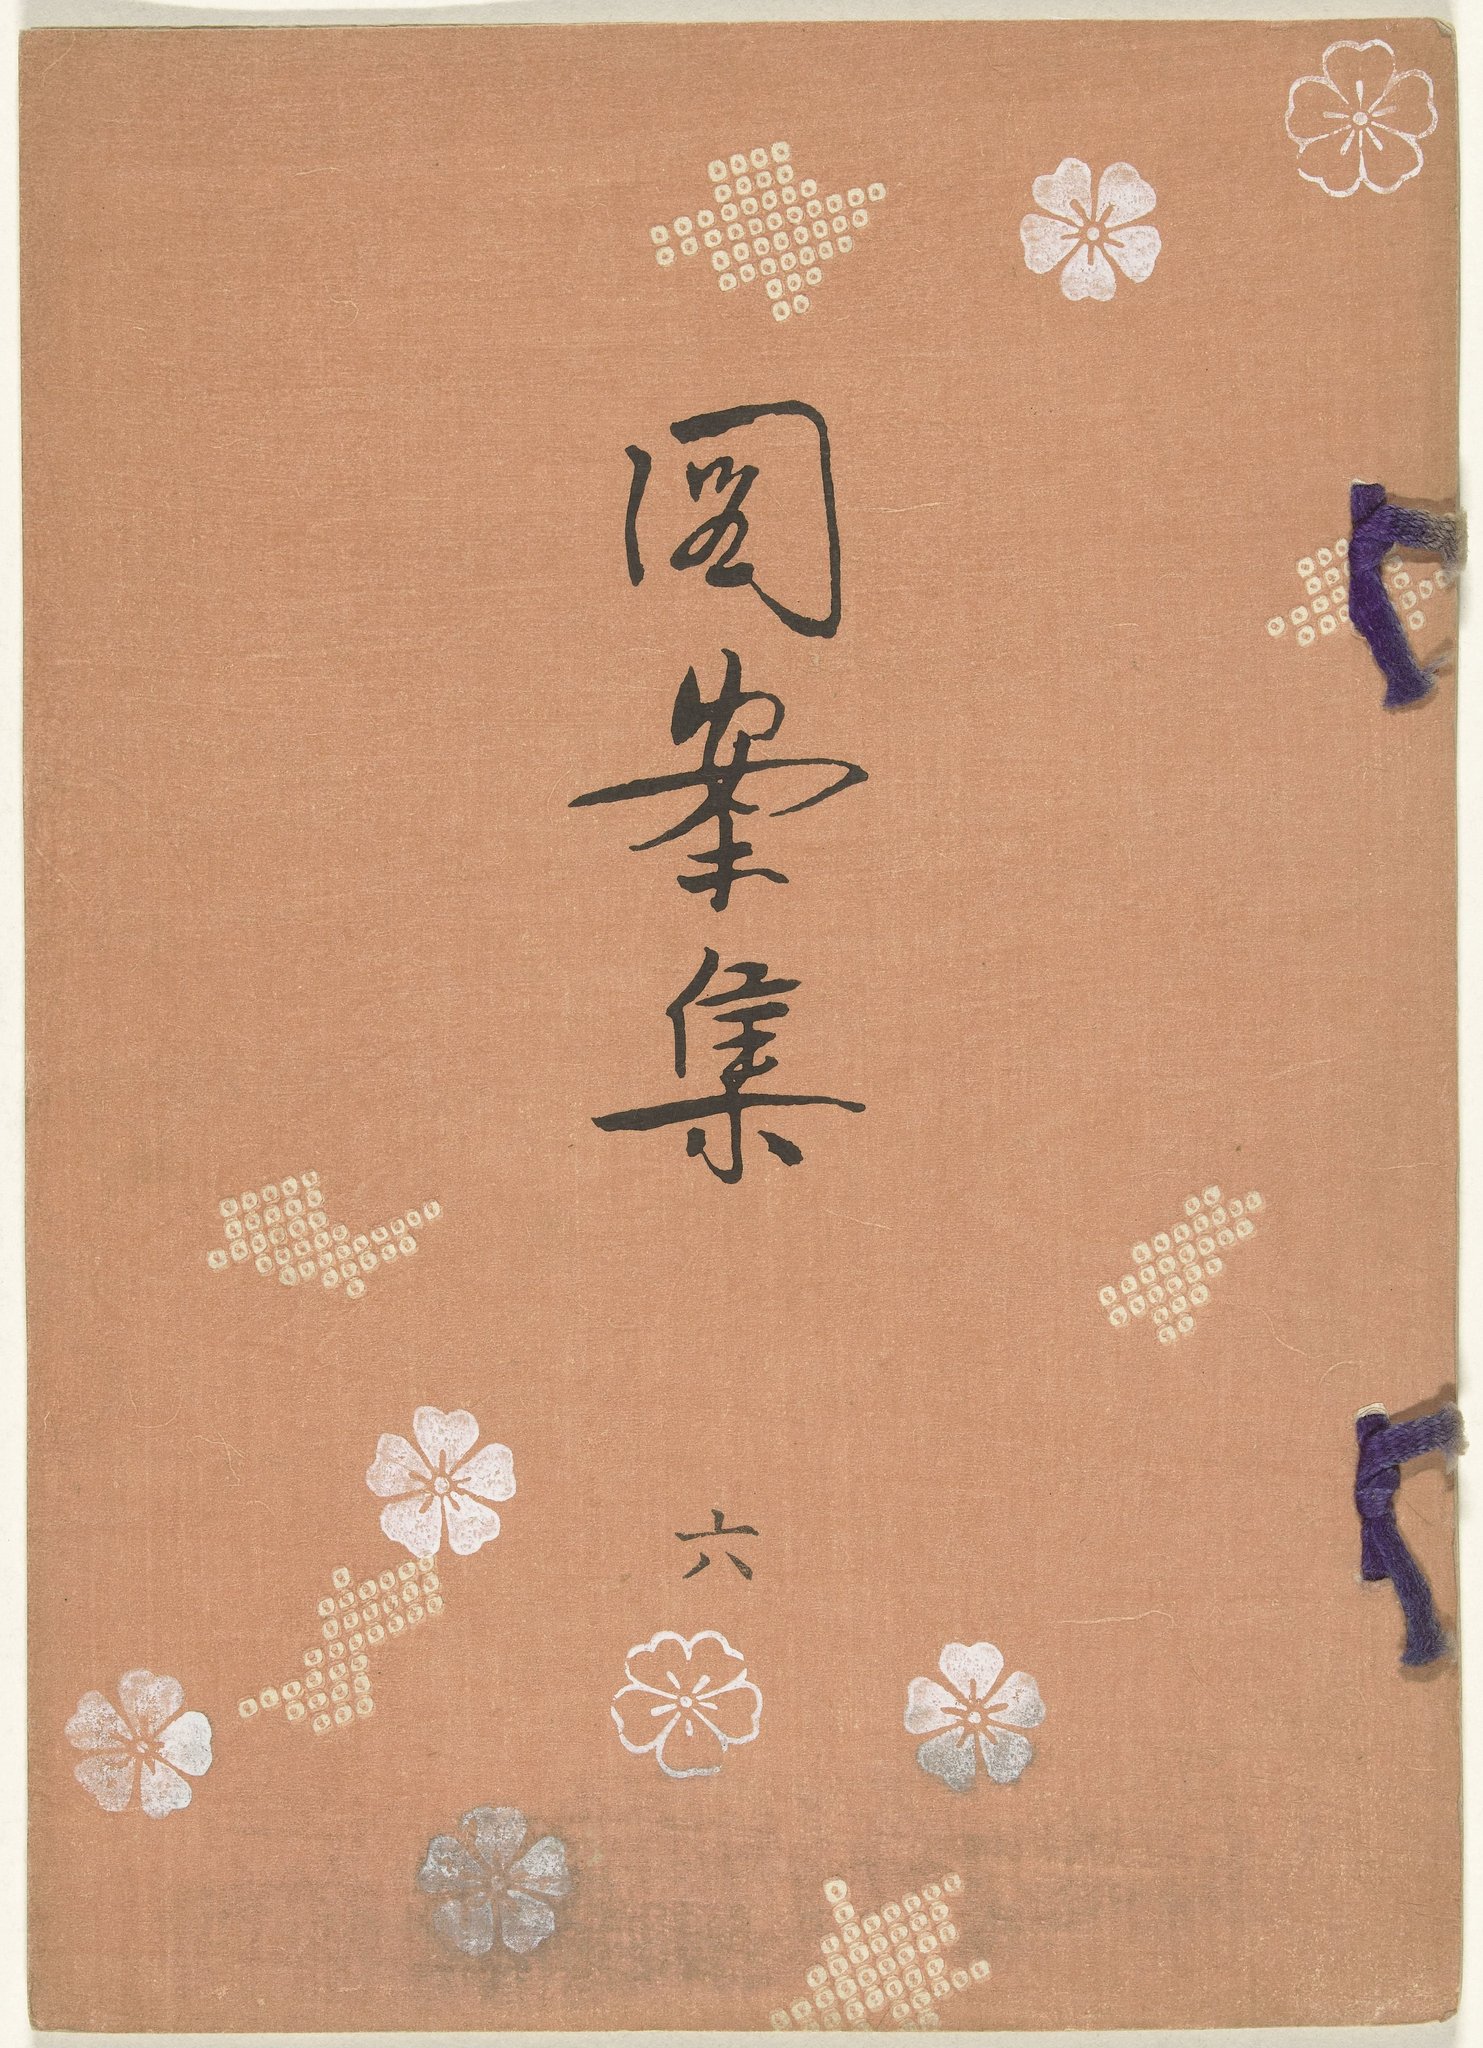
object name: book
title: Zuan shu roku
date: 1901-1902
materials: gold powder, paper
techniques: woodcut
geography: kyoto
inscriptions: date